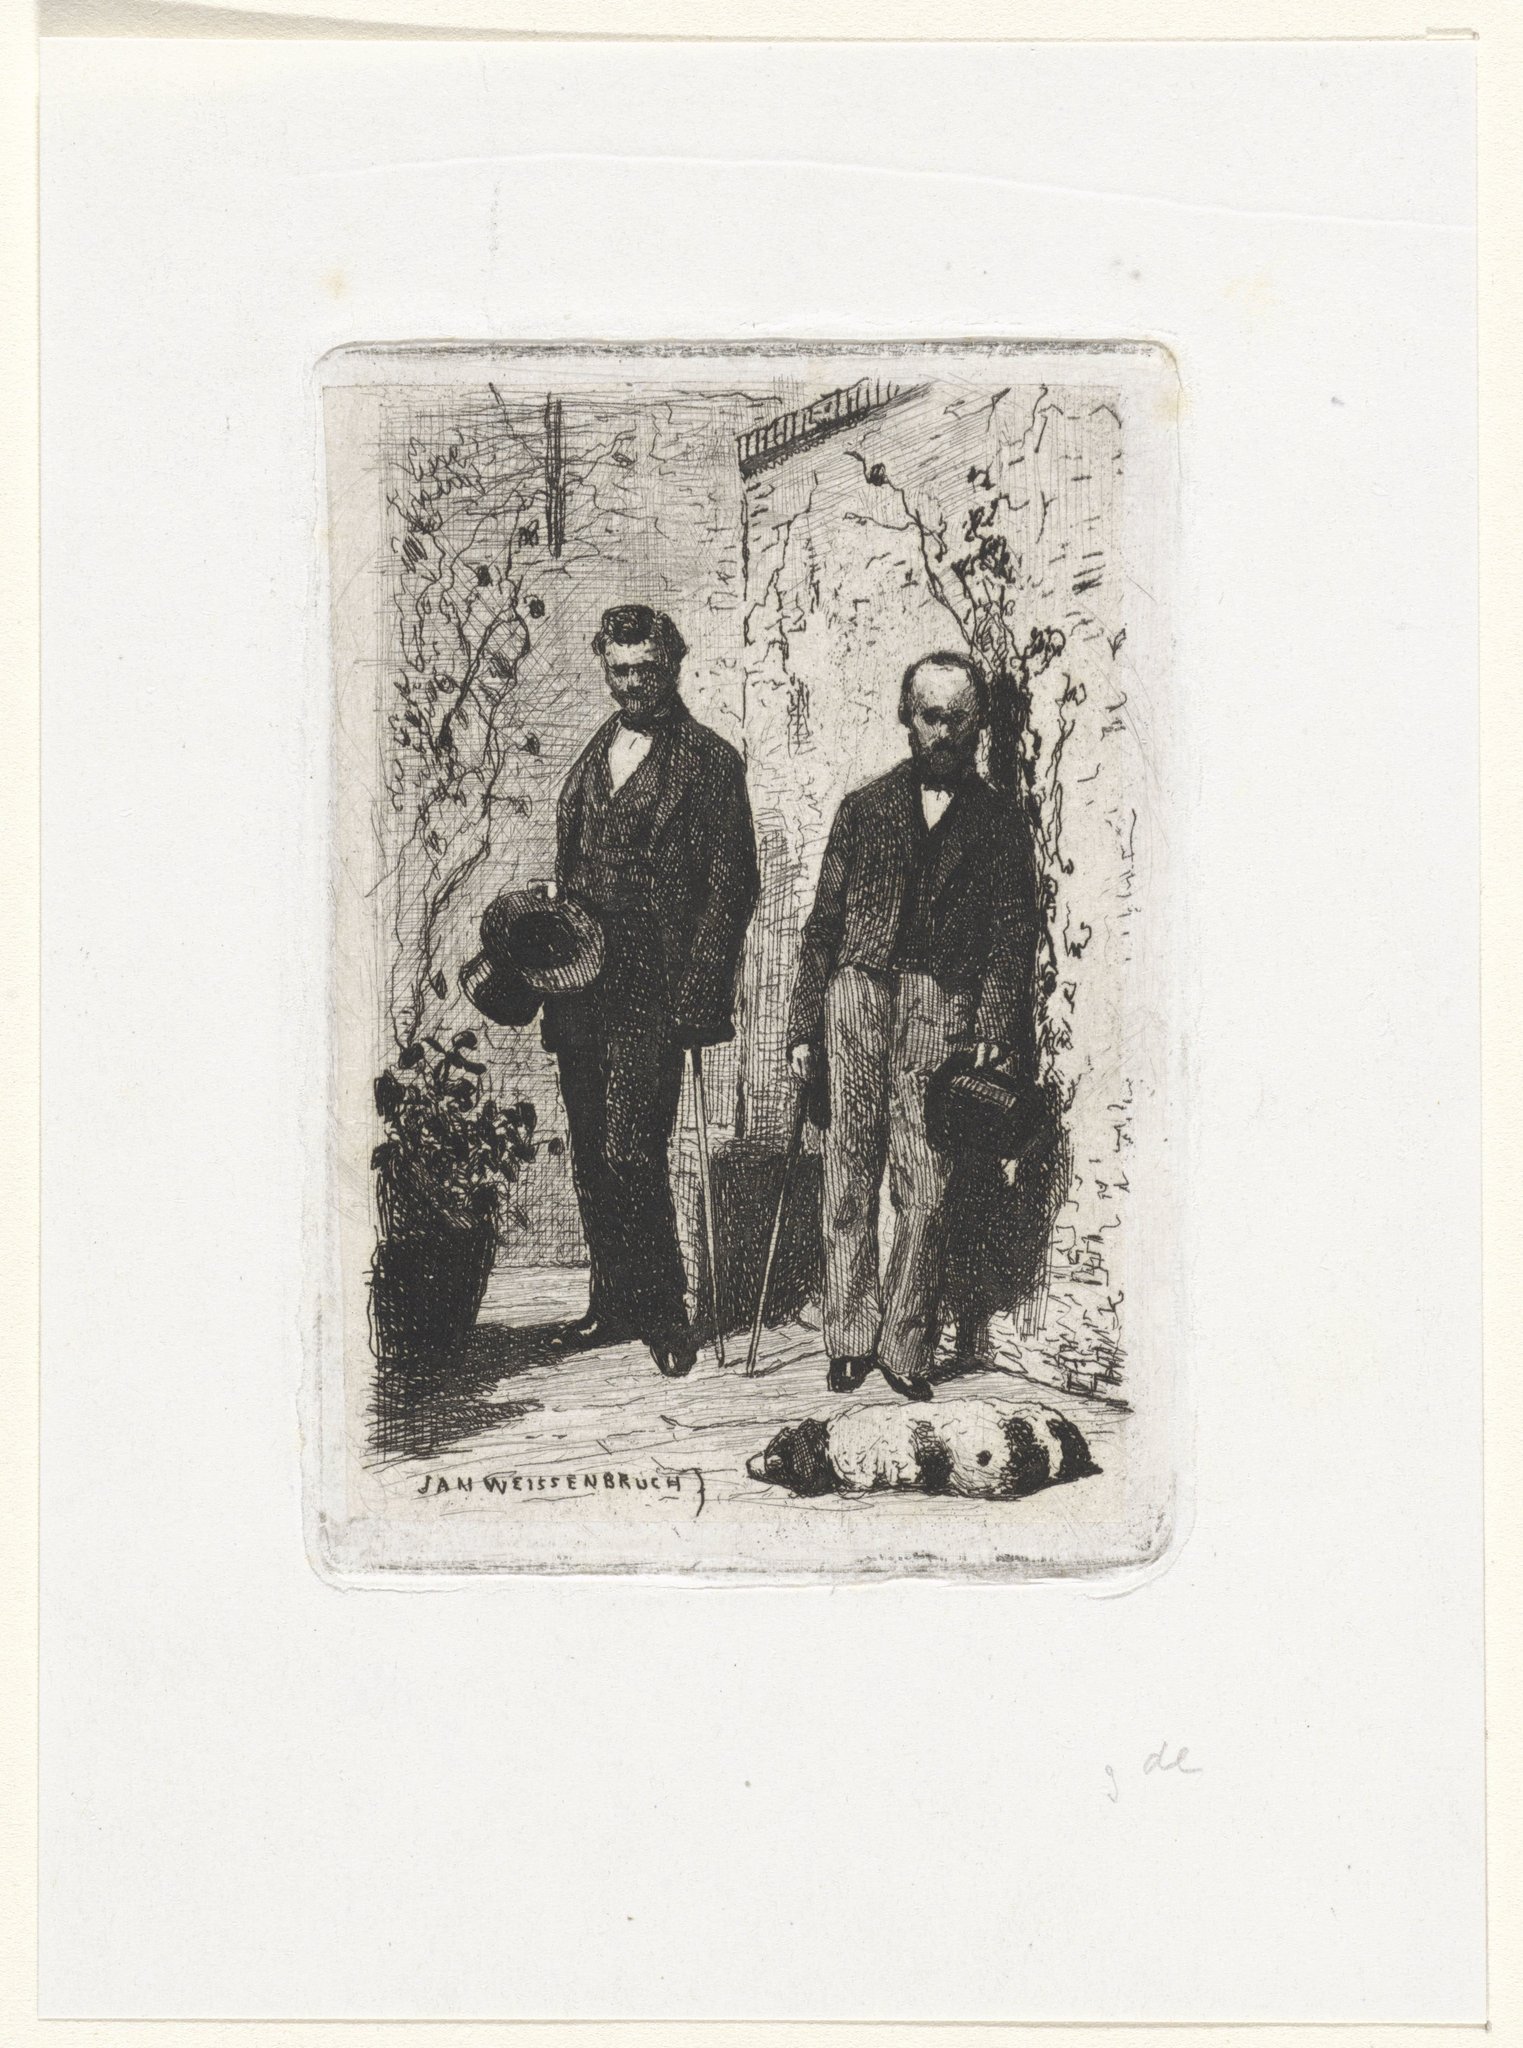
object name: print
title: Zelfportret met Frederik Hendrik Weissenbruch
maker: jan weissenbruch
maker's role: painter, print maker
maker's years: 1822-1880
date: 1837-1880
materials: paper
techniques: etching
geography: the hague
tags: painter, print maker, jan weissenbruch, draughtsman, frederik hendrik weissenbruch, plants; vegetation, adult man, portrait, self-portrait of artist, dog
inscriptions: collector's mark: Lugt 2228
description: De kunstenaar Frederik Hendrik Weissenbruch (l) en zijn broer Jan Weissenbruch (r) staan bij een muur. Ze houden allebei een stok en een hoge hoed vast. Voor hen ligt een hond te slapen.